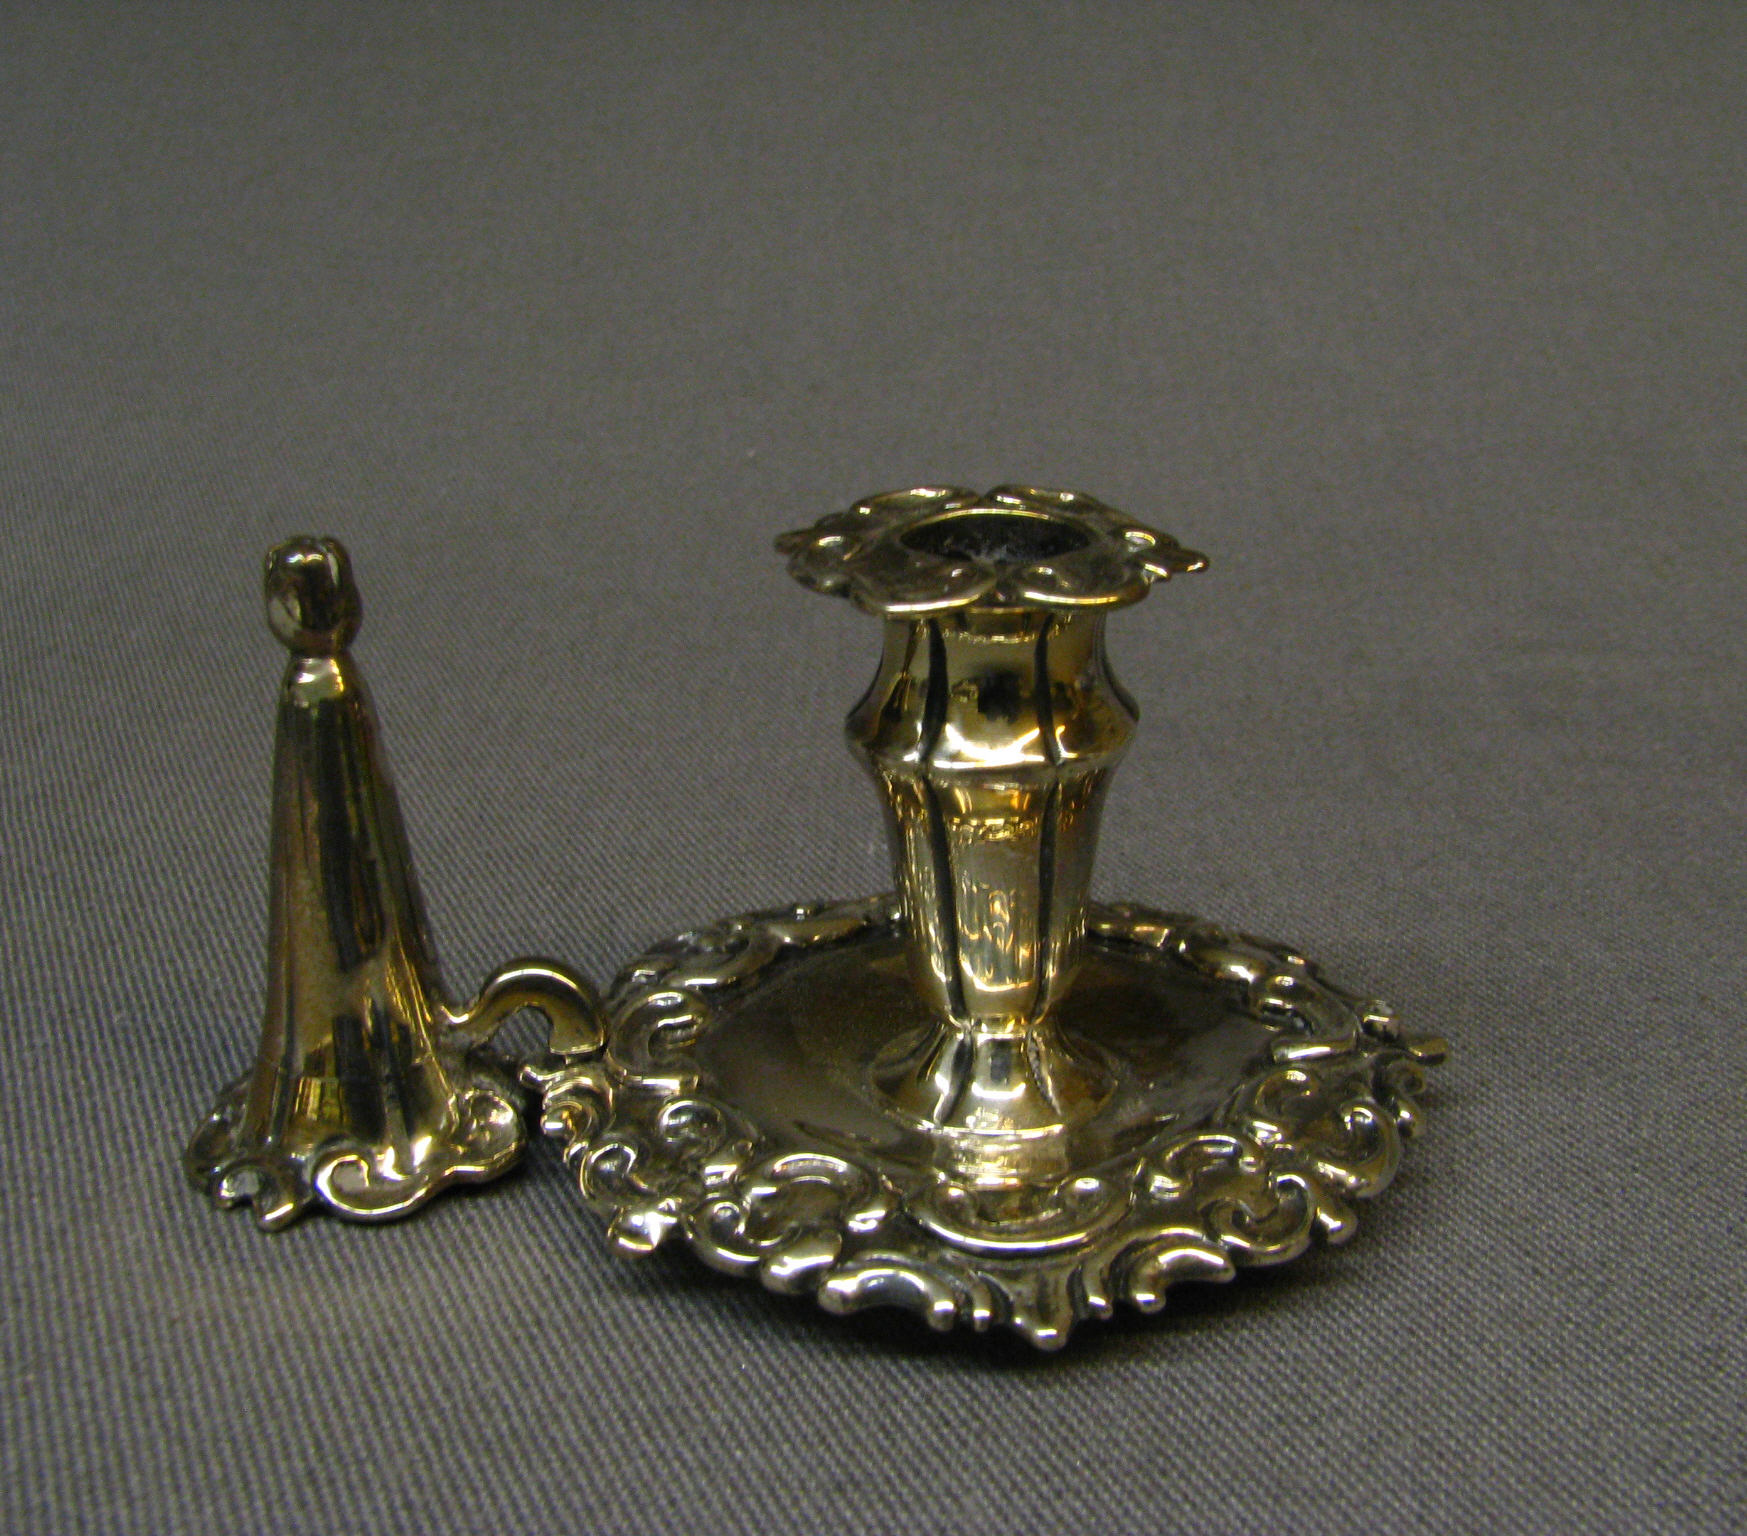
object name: taperstick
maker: george reid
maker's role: maker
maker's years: 1811-1849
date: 1848-1849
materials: silver